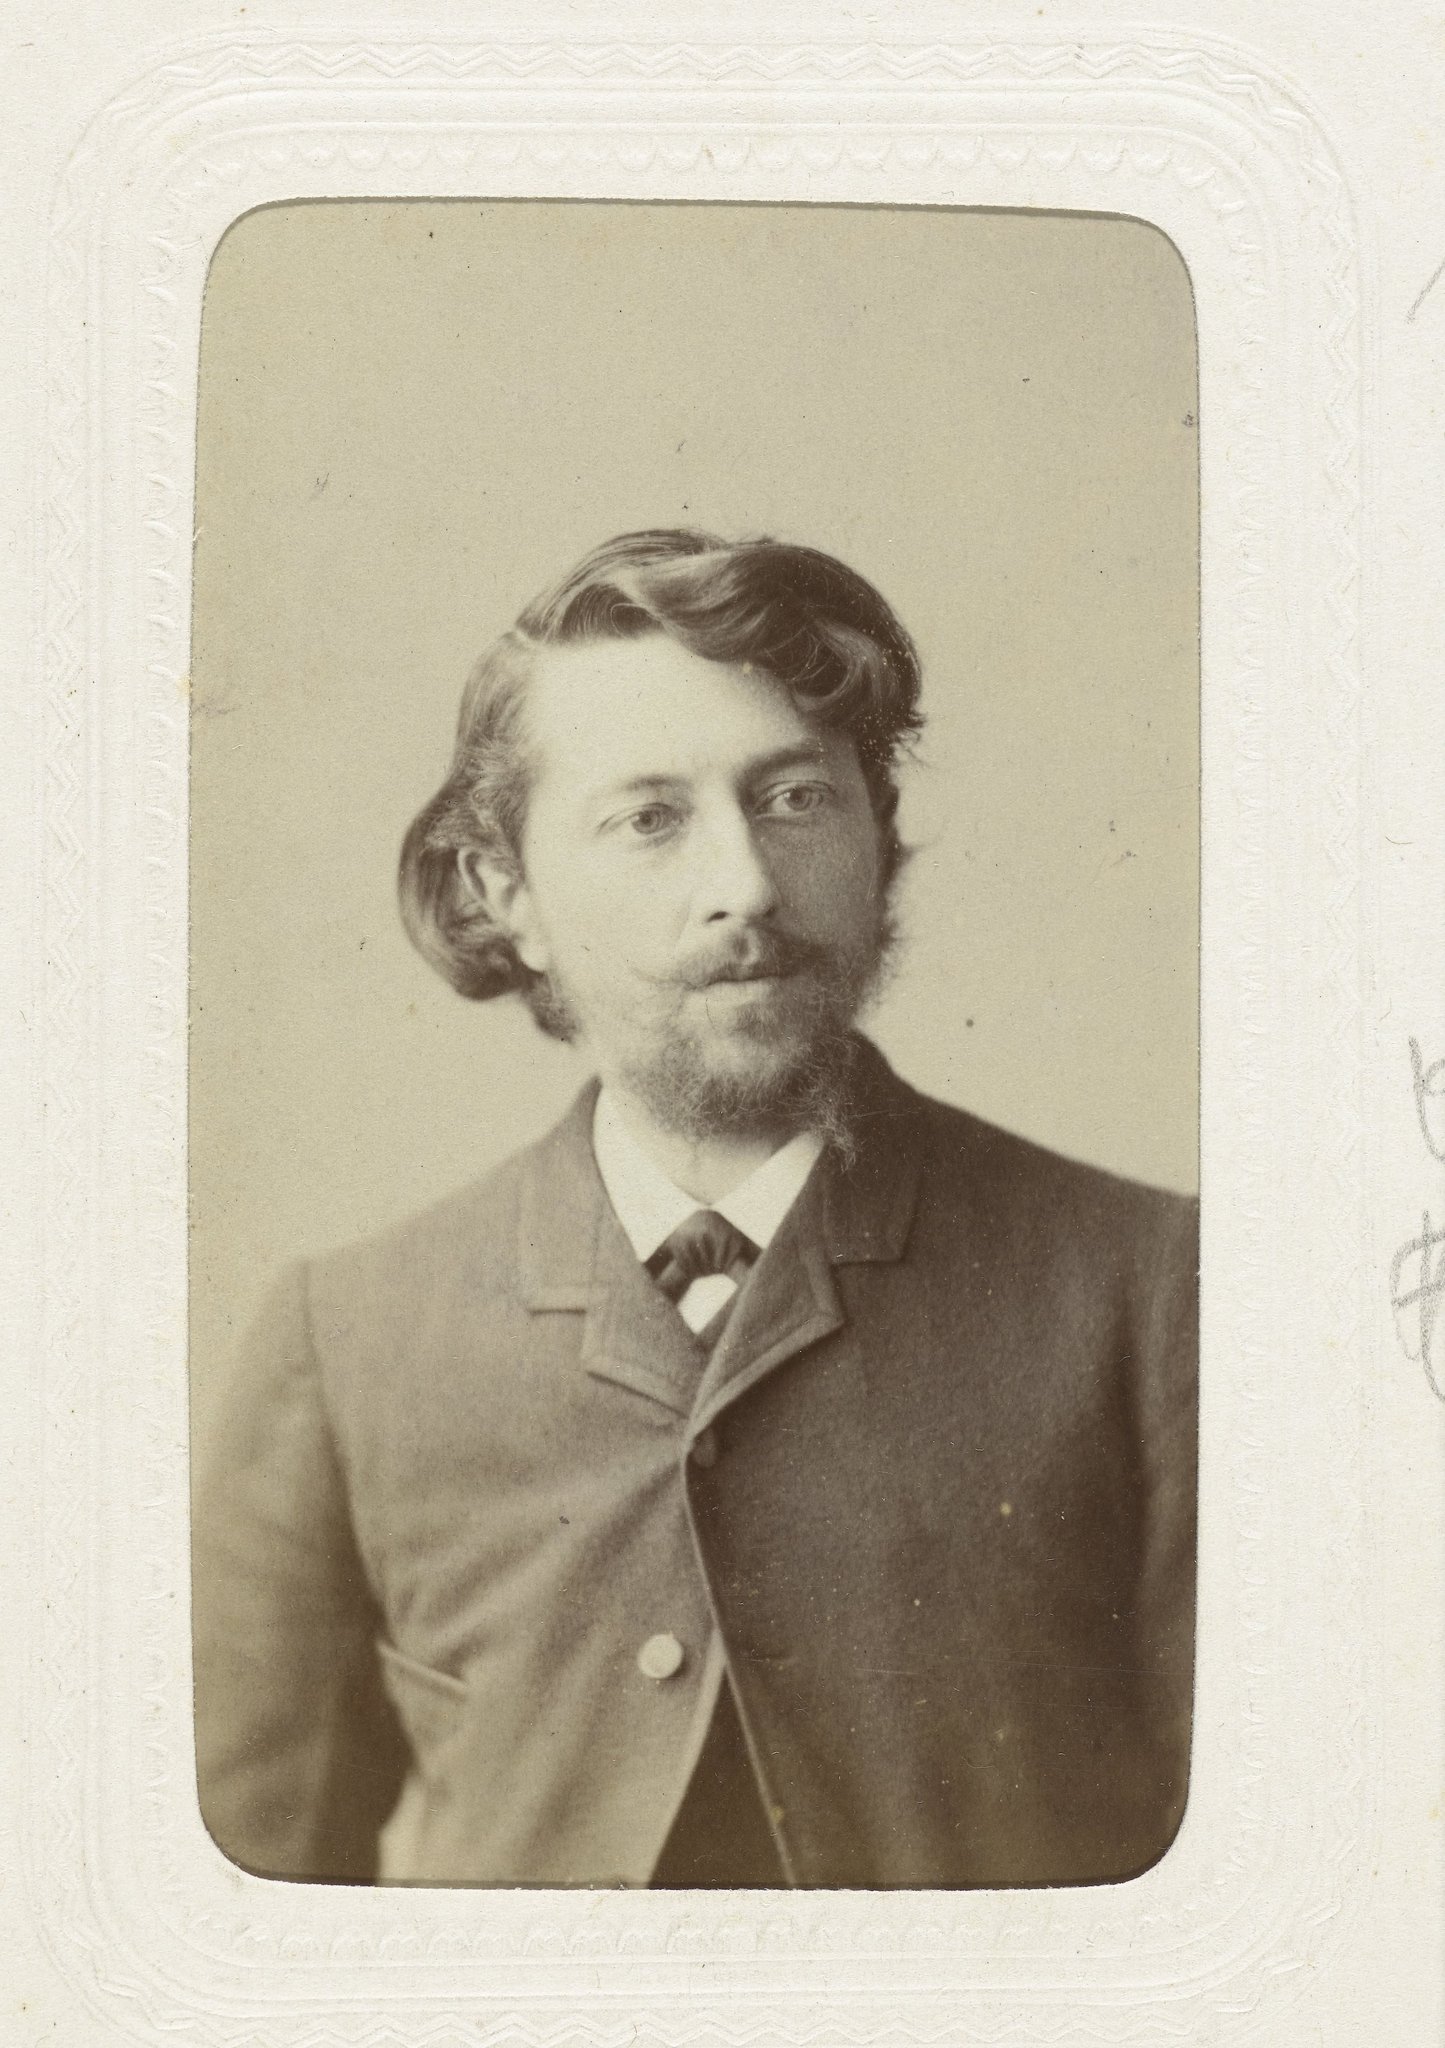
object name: carte de visite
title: Studioportret van een jongeman met halflang haar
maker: albert greiner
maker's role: fotograaf, fotostudio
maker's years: 1833-1890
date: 1863-1866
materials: cardboard, paper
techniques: albumen print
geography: amsterdam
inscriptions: name: ‘Albert Greiner, Amsterdam’